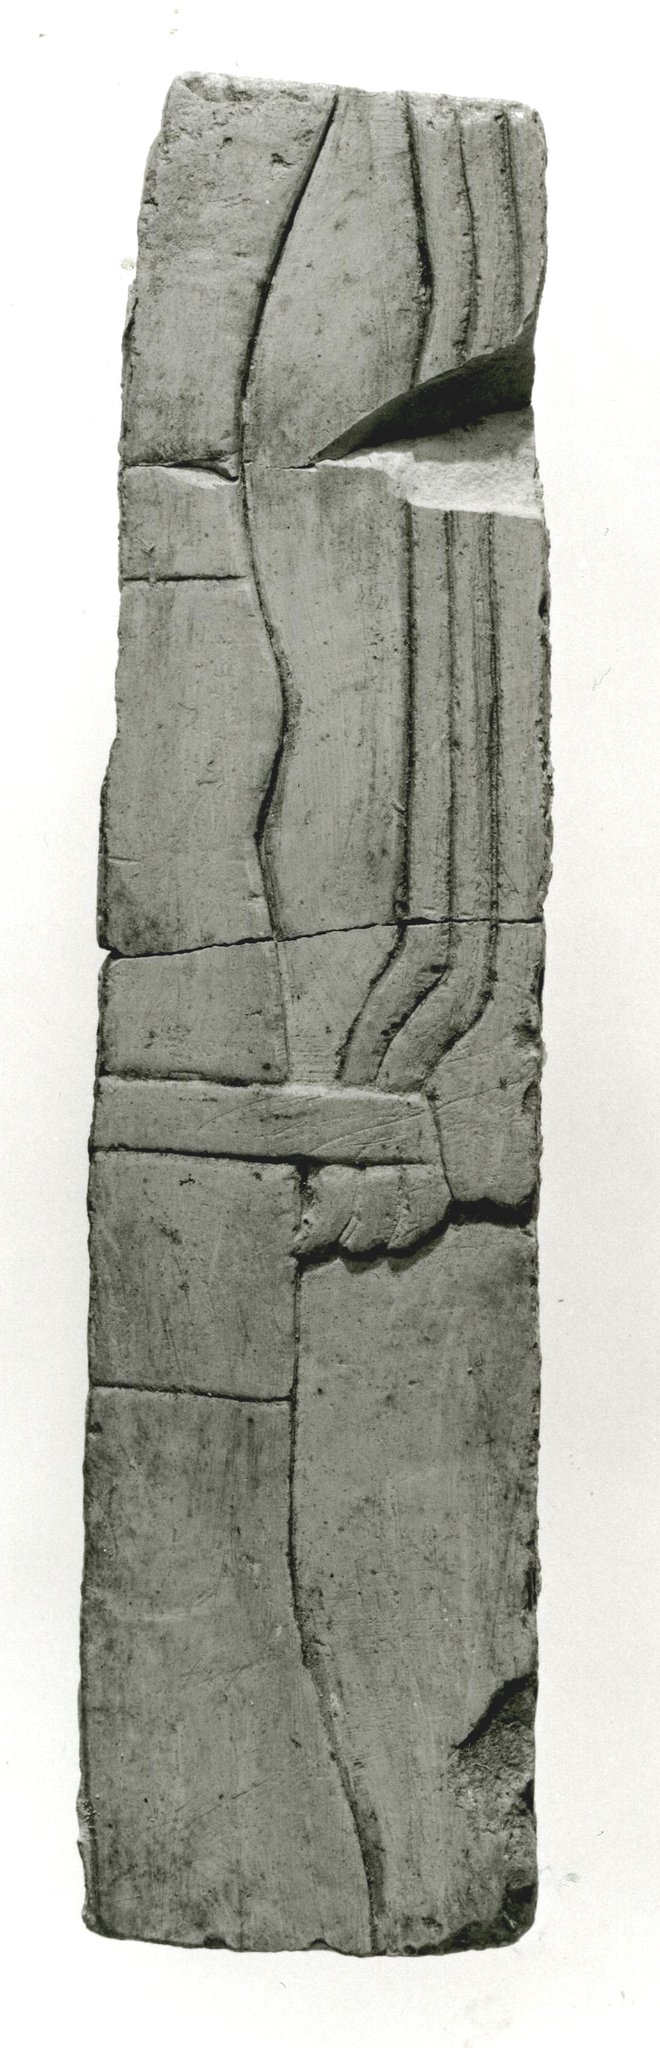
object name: relief, tomb of nespekashuty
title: Raised relief fragment with three men holding a rope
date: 664-610 BCE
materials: limestone, varnish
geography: egypt